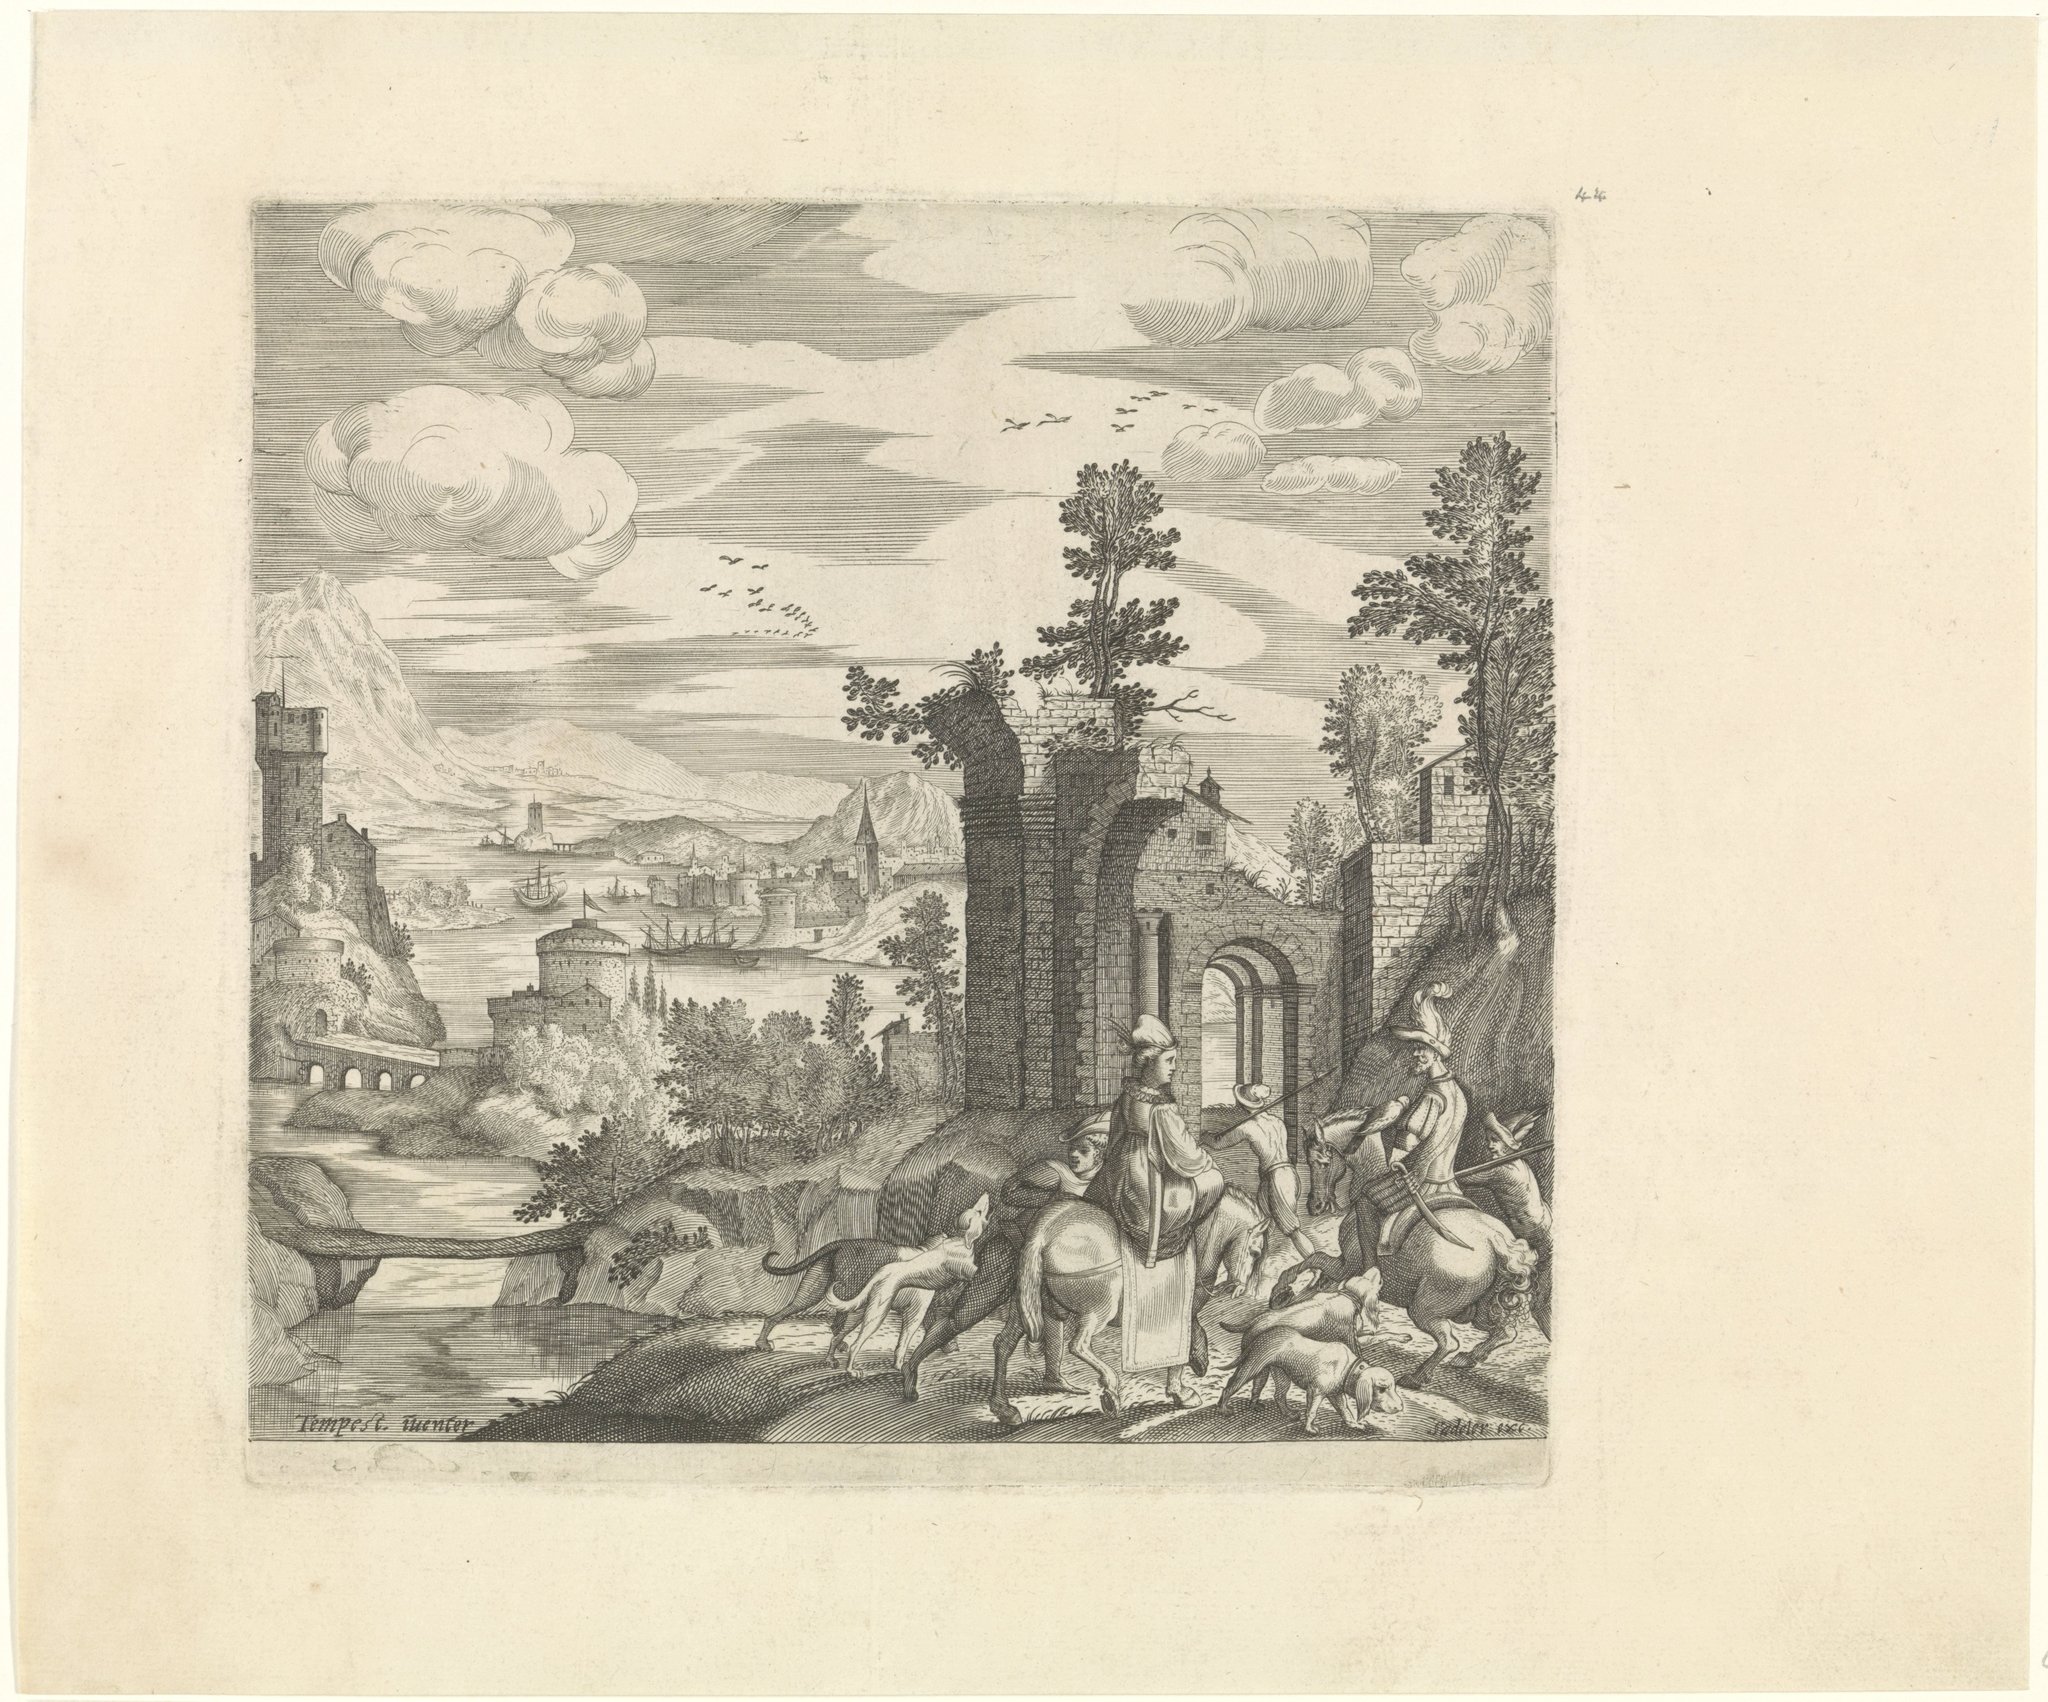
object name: print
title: Landschap met jagers te paard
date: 1580-1600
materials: paper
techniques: engraving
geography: italy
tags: hunting dogs, river, hunter, mountains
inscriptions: collector's mark: Lugt 2760, collector's mark: Lugt 2228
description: Een groep jagers te paard met jachthonden voor een ruïne. Op de achtergrond een rivier in een berglandschao. De prent maakt deel uit van een vijfdelige prentserie met Italiaanse landschappen.